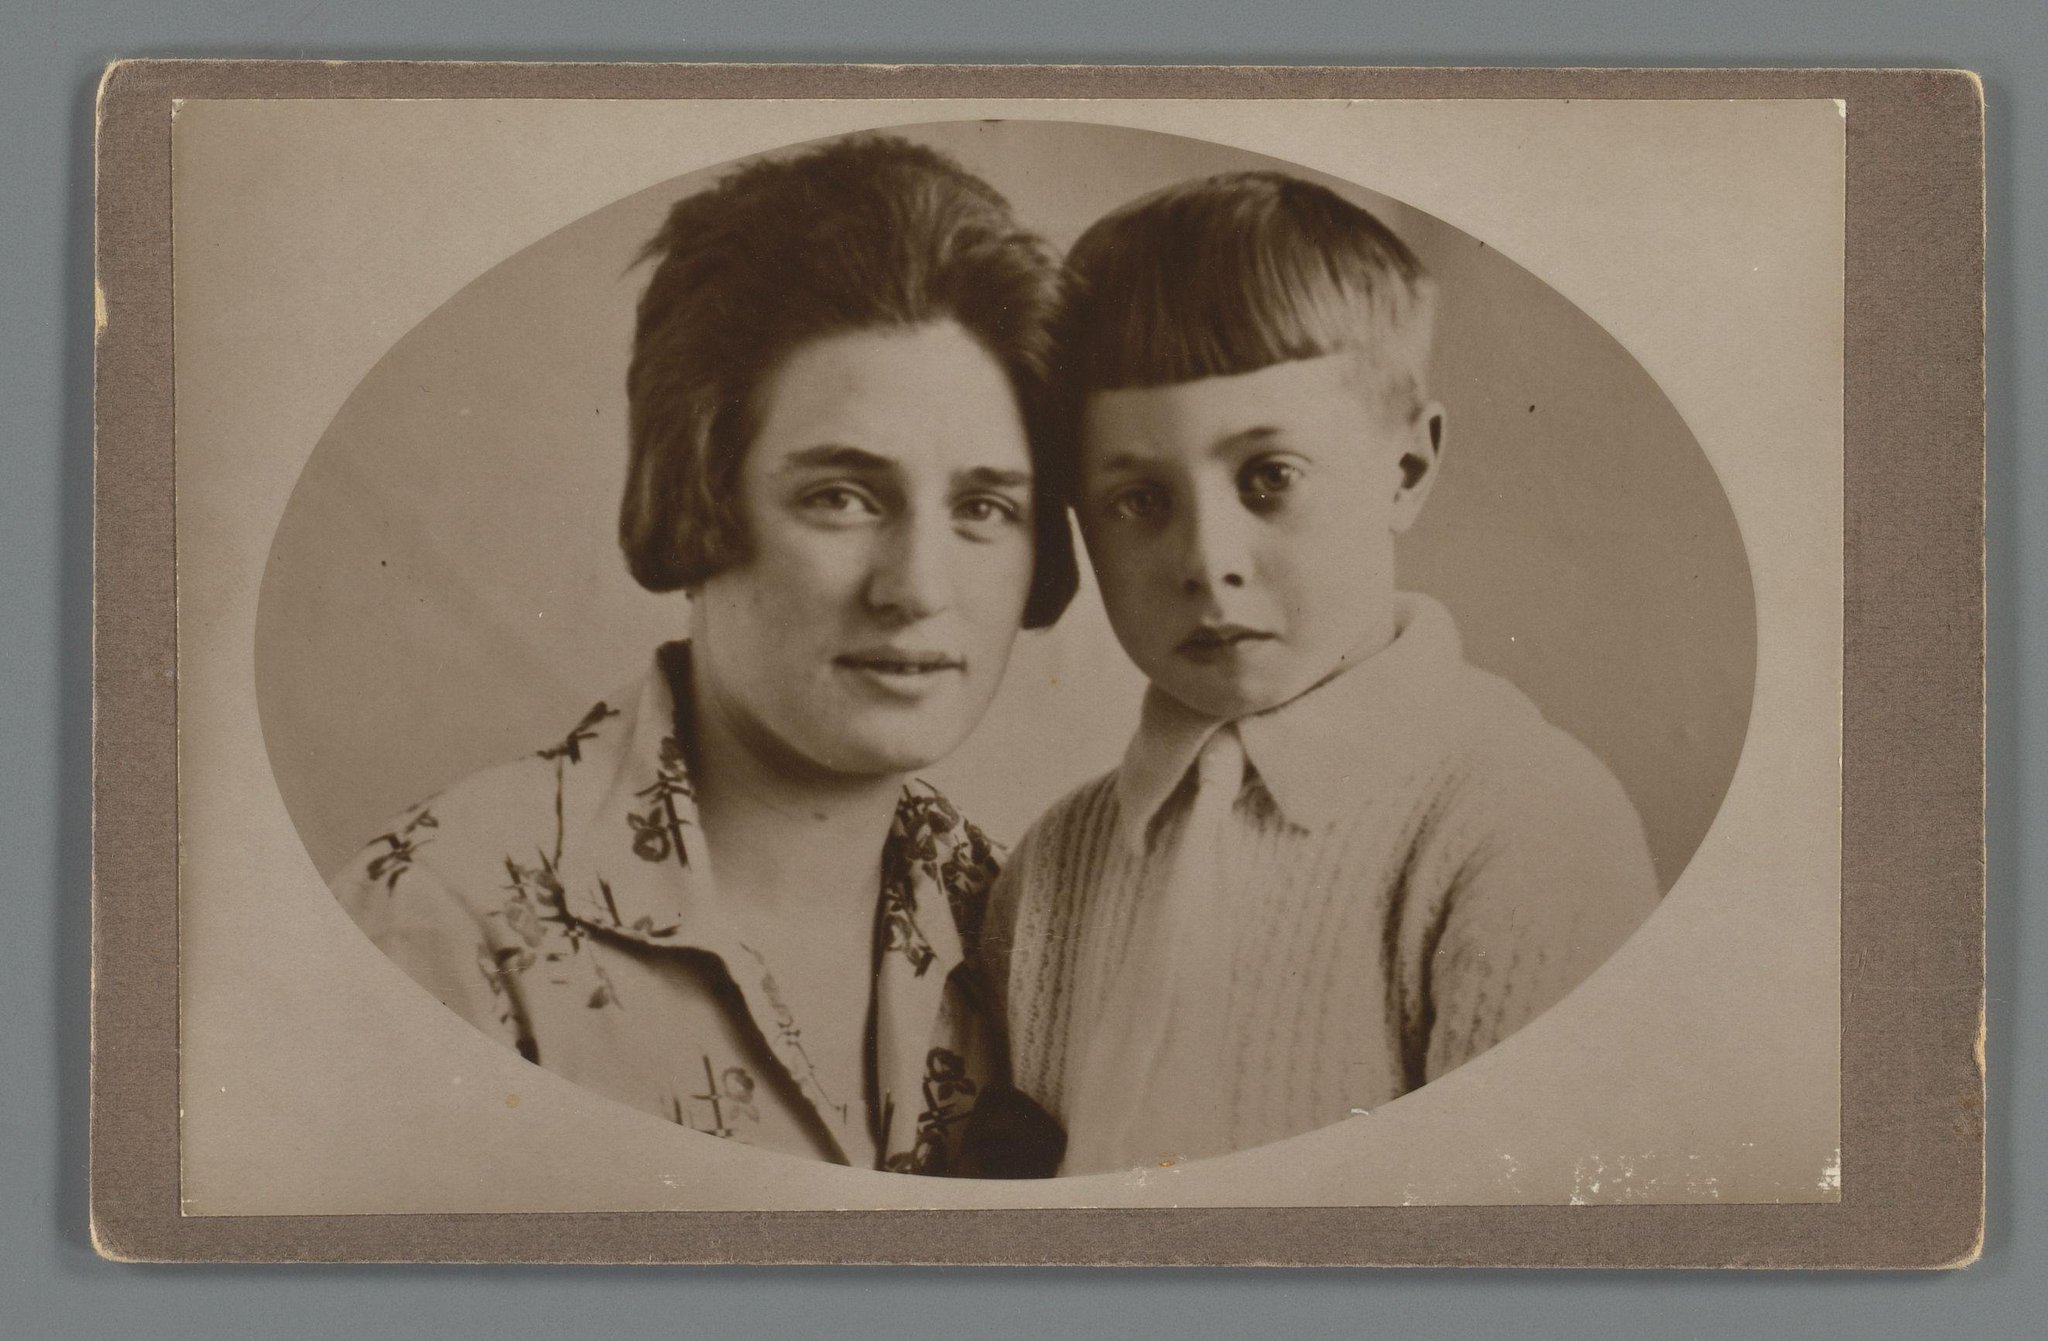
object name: photograph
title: Portret van Jetty Merks en Loutje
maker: Anonymous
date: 1930-1950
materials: paper, cardboard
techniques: gelatin silver print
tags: historical persons - bb - woman, portrait of cabaret-artiste, mother and child(ren), woman and child(ren) (family group)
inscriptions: inscription: ‘Beste Jongens/ Hoe vinden jullie dit/ product. Vele groeten/ van ons/ Jetty Lou en Loutje’